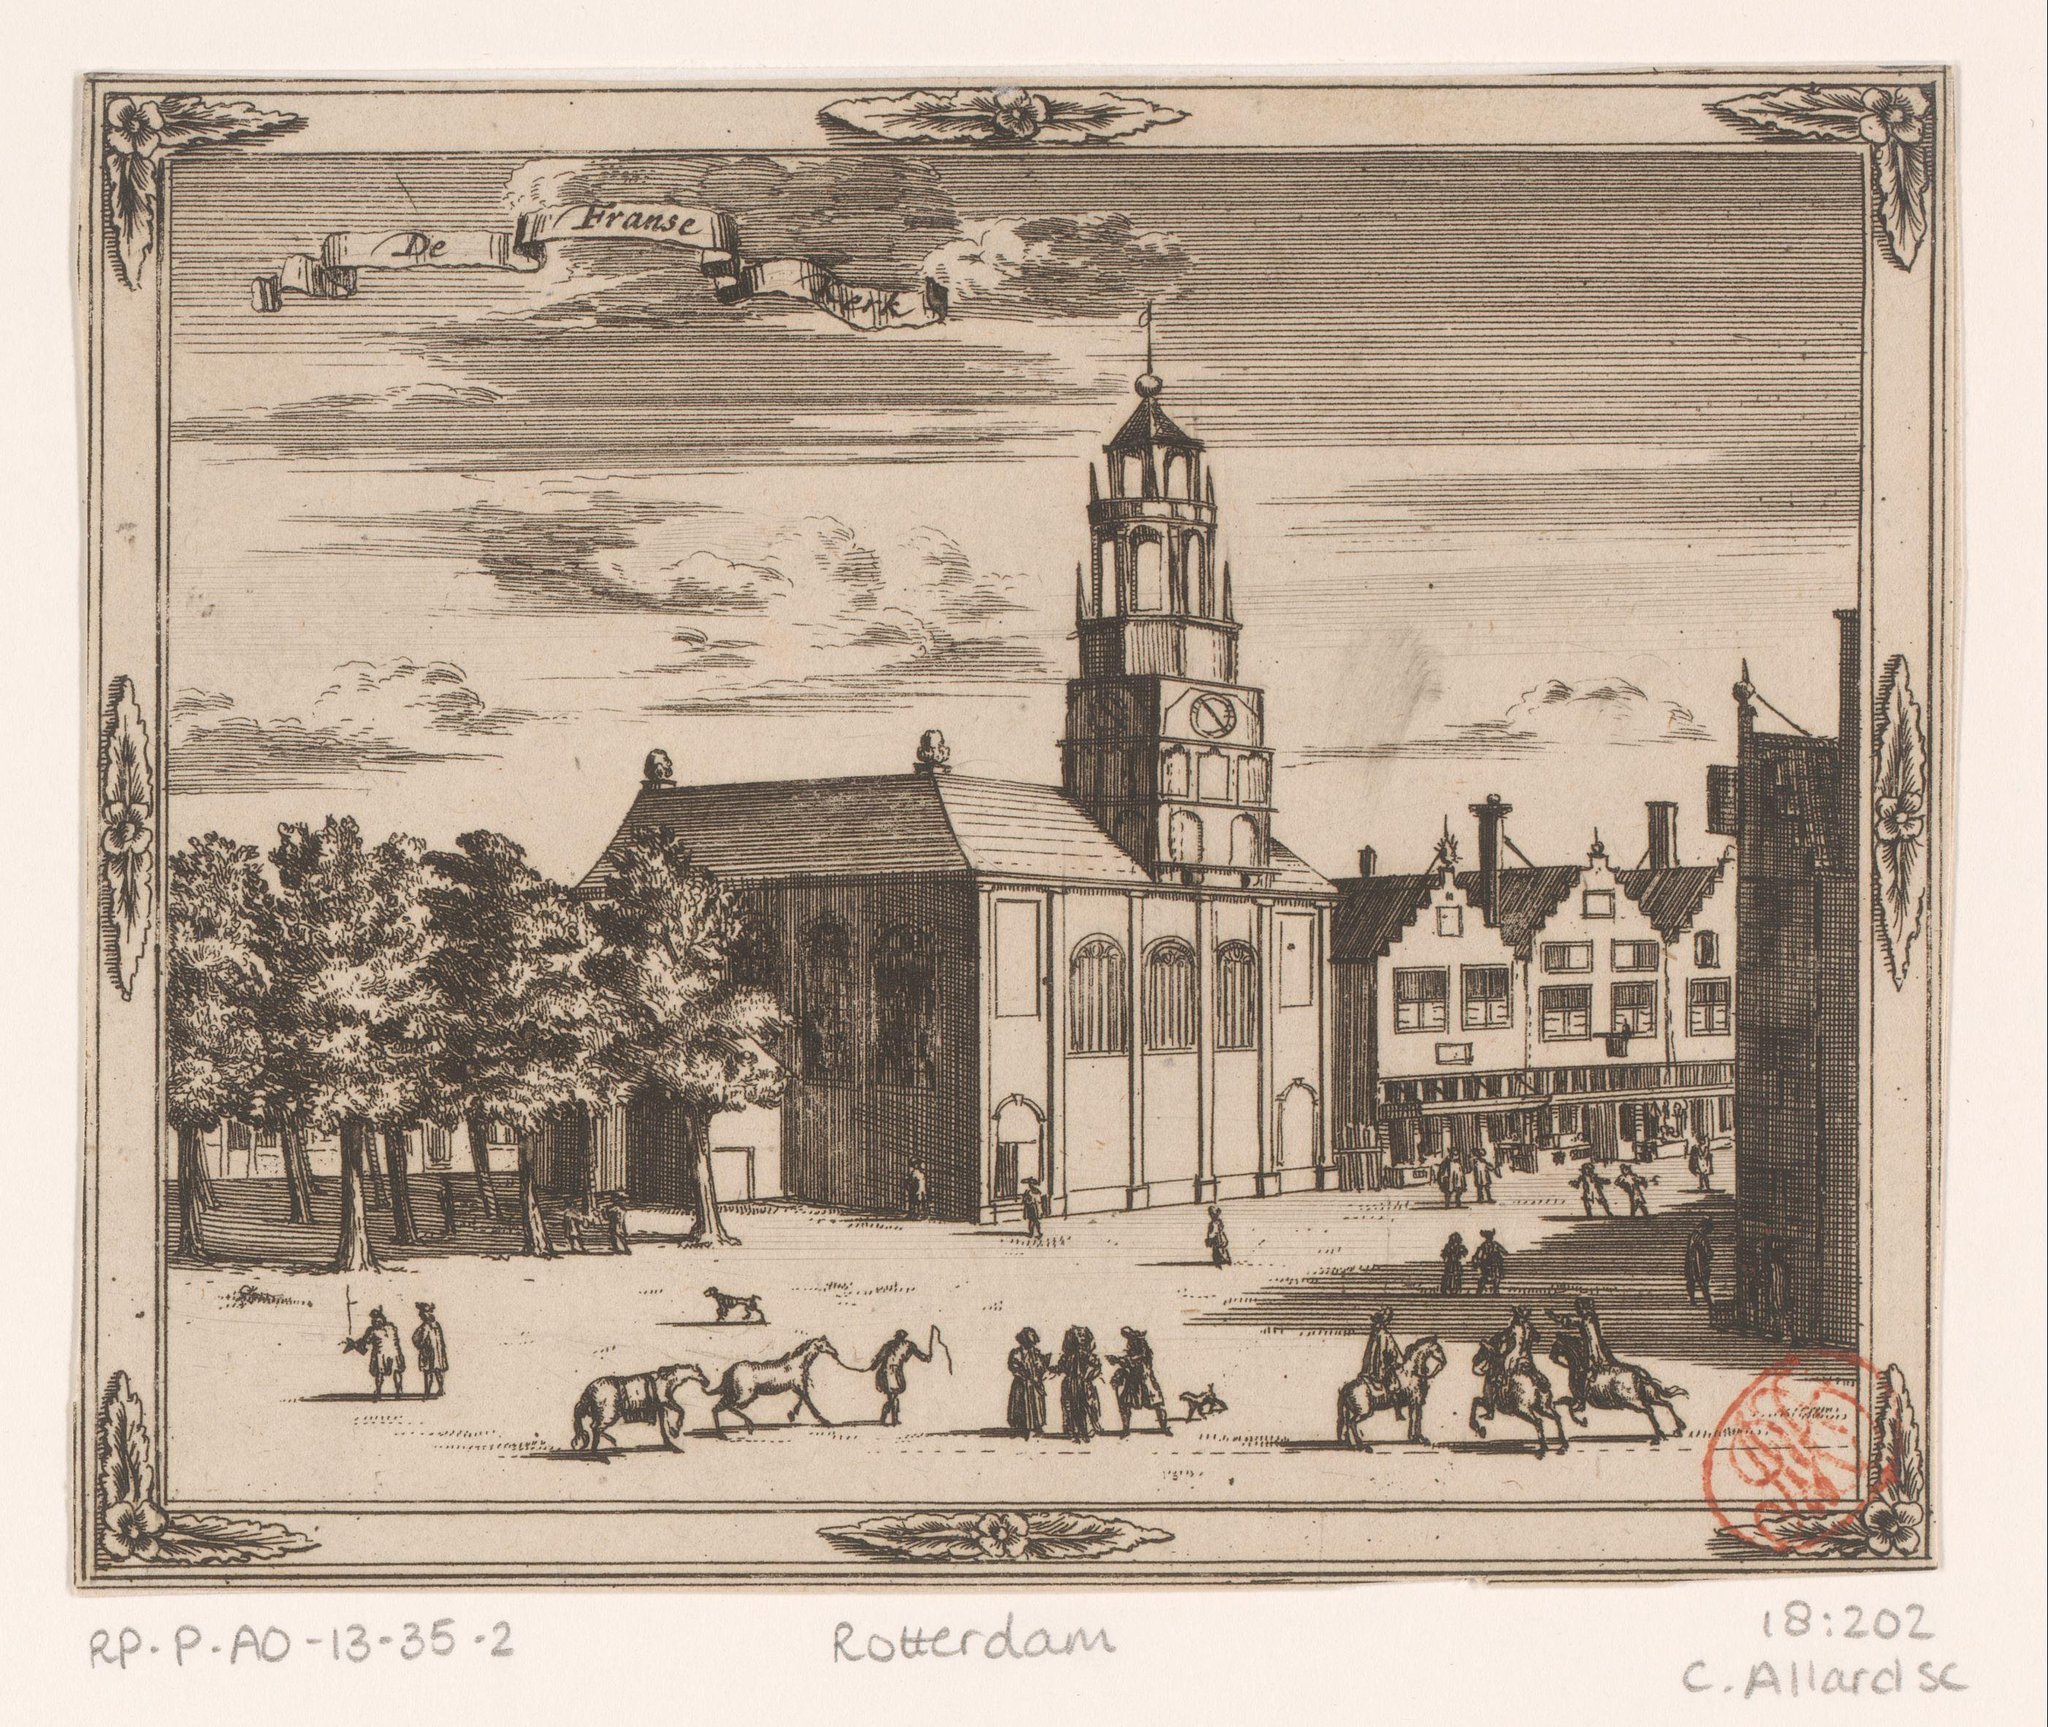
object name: print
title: Les principaux edifices et vues de la ville de Rotterdam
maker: jacobus harrewijn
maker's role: print maker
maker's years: 1660-1740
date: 1715-1730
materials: paper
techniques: etching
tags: church (exterior), street (+ city(-scape) with figures, staffage)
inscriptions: collector's mark: Lugt 195, collector's mark: Lugt 2228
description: Prent vermoedelijk eerst met dertien andere stadsgezichten uitgegeven als onderdeel van de sierrand van – in ieder geval de derde staat en mogelijk ook de tweede van – de plattegrond 'Tabula Roterodami Novissima' (zie RP-P-AO-13-11). Later nog een keer als onderdeel van een prentserie uitgegeven: Les principaux edifices et vues de la ville de Rotterdam. Le tout fidèlement dessiné sur les lieux. Leiden: Pieter van der Aa, s.a. [adres 'dans l'Academie', dus 1715-1730]. De platen zijn voor zover na te gaan ongewijzigd gebleven.